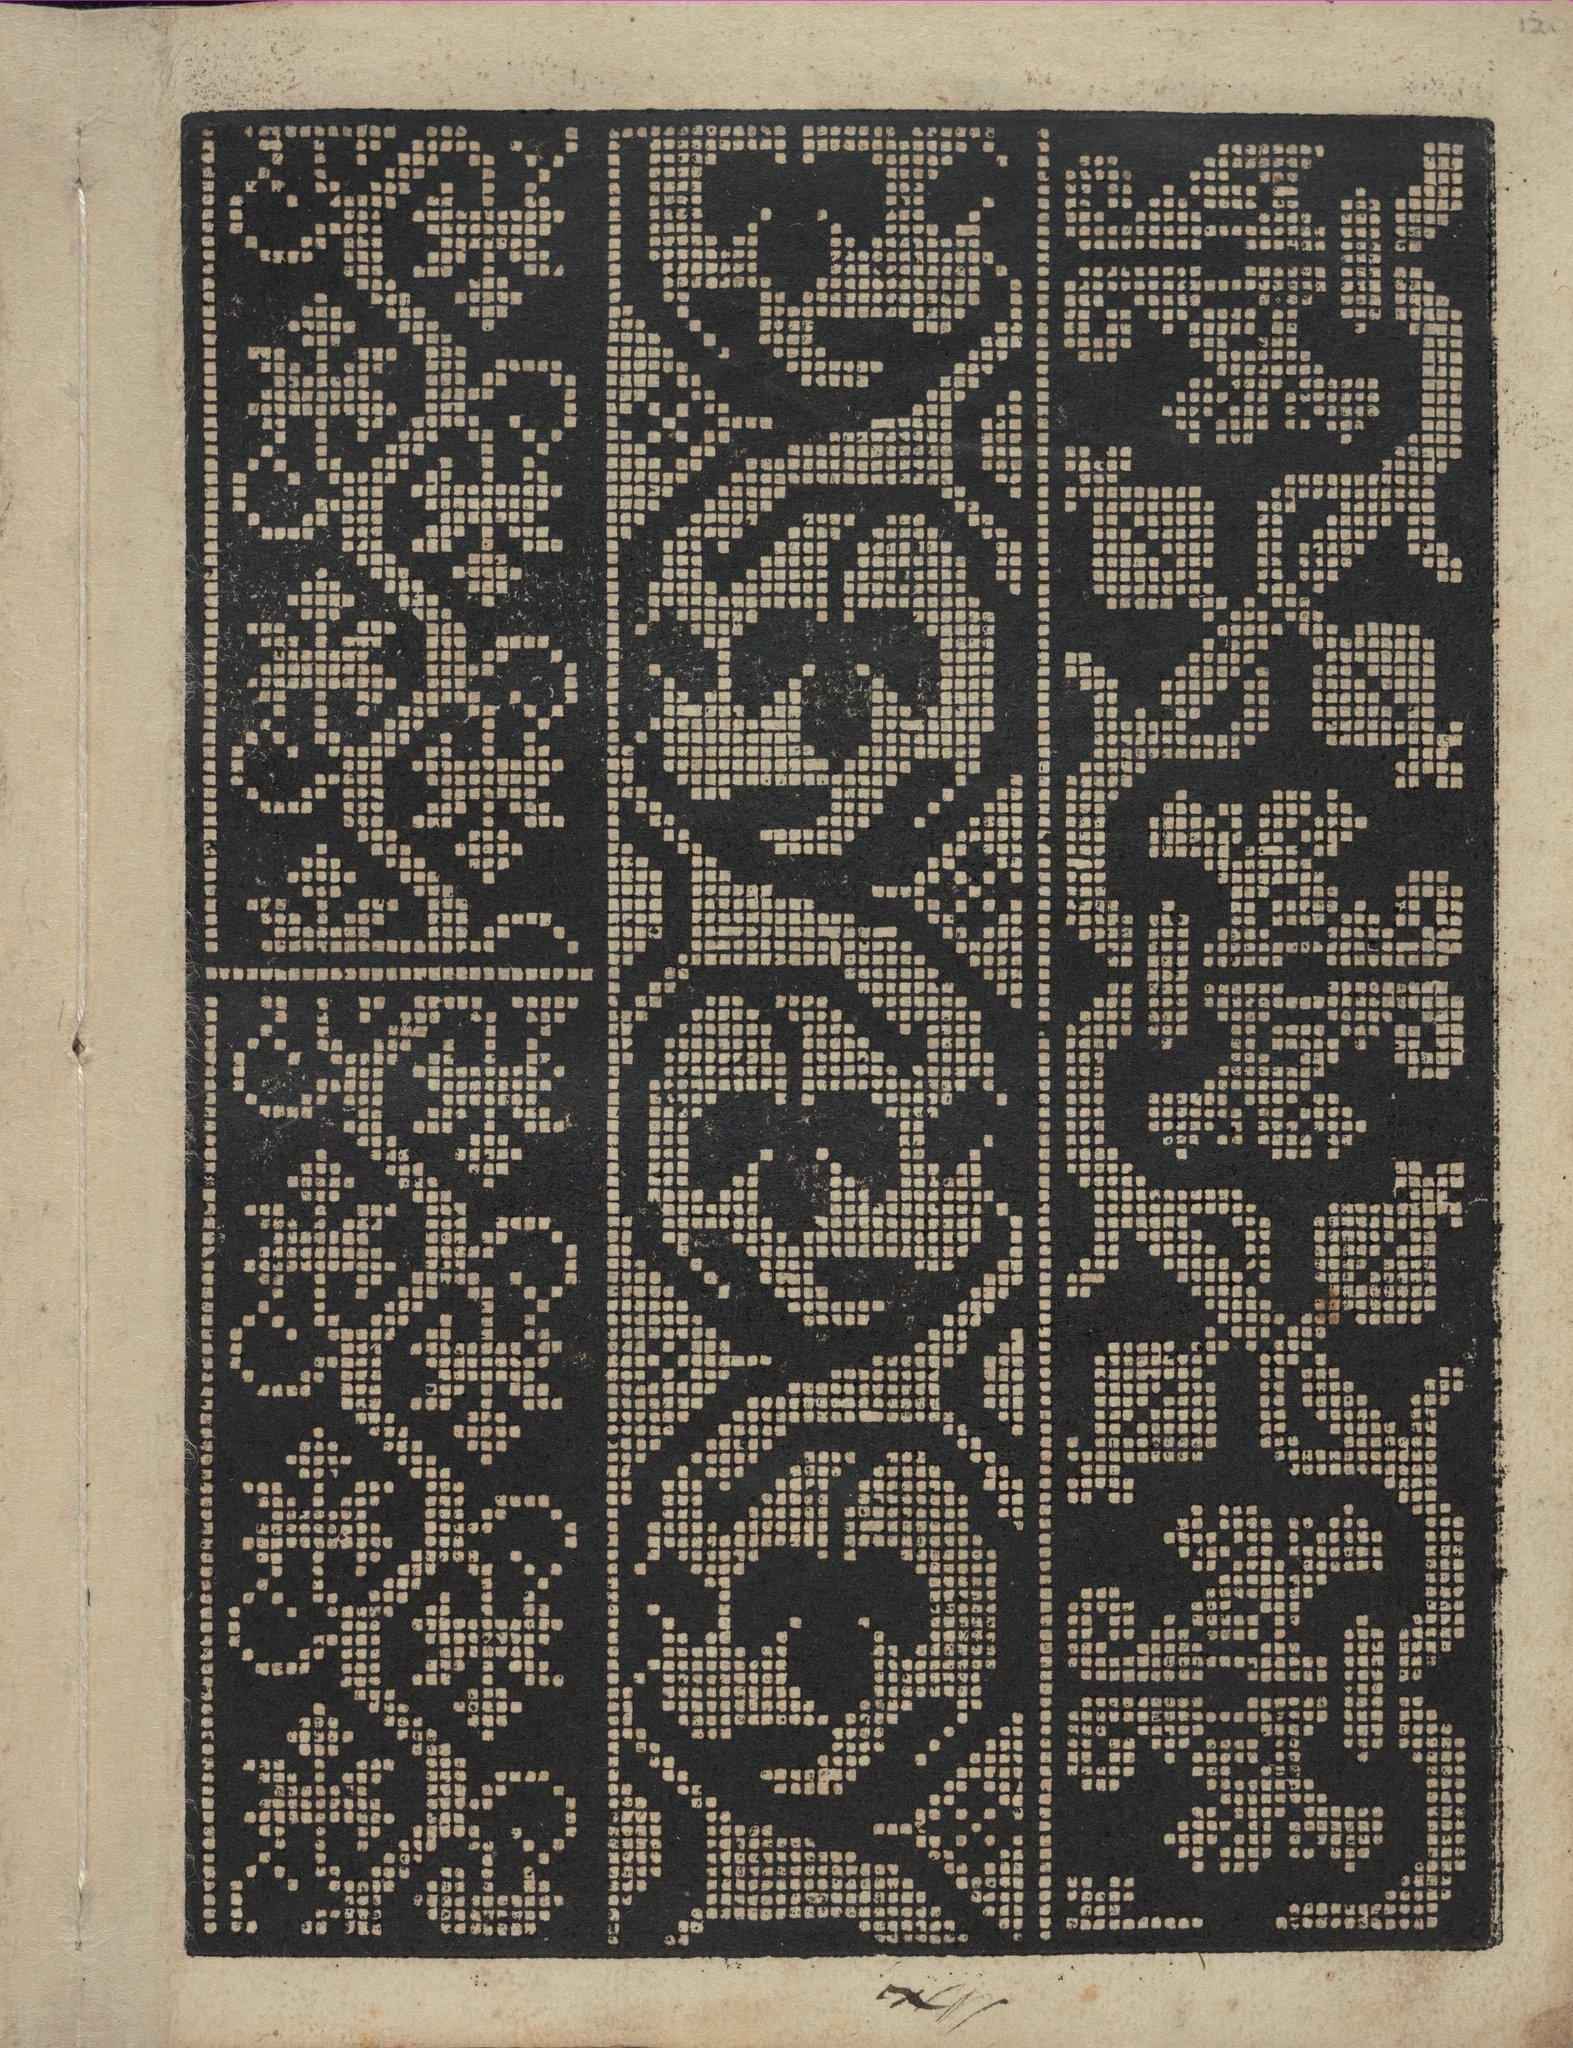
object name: book print ornament architecture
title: Libbretto nouellamete composto per maestro Domenico da Sera...lauorare di ogni sorte di punti, page 12 (recto)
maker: domenico da sera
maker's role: publisher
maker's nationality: french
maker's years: 1500-1599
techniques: woodcut